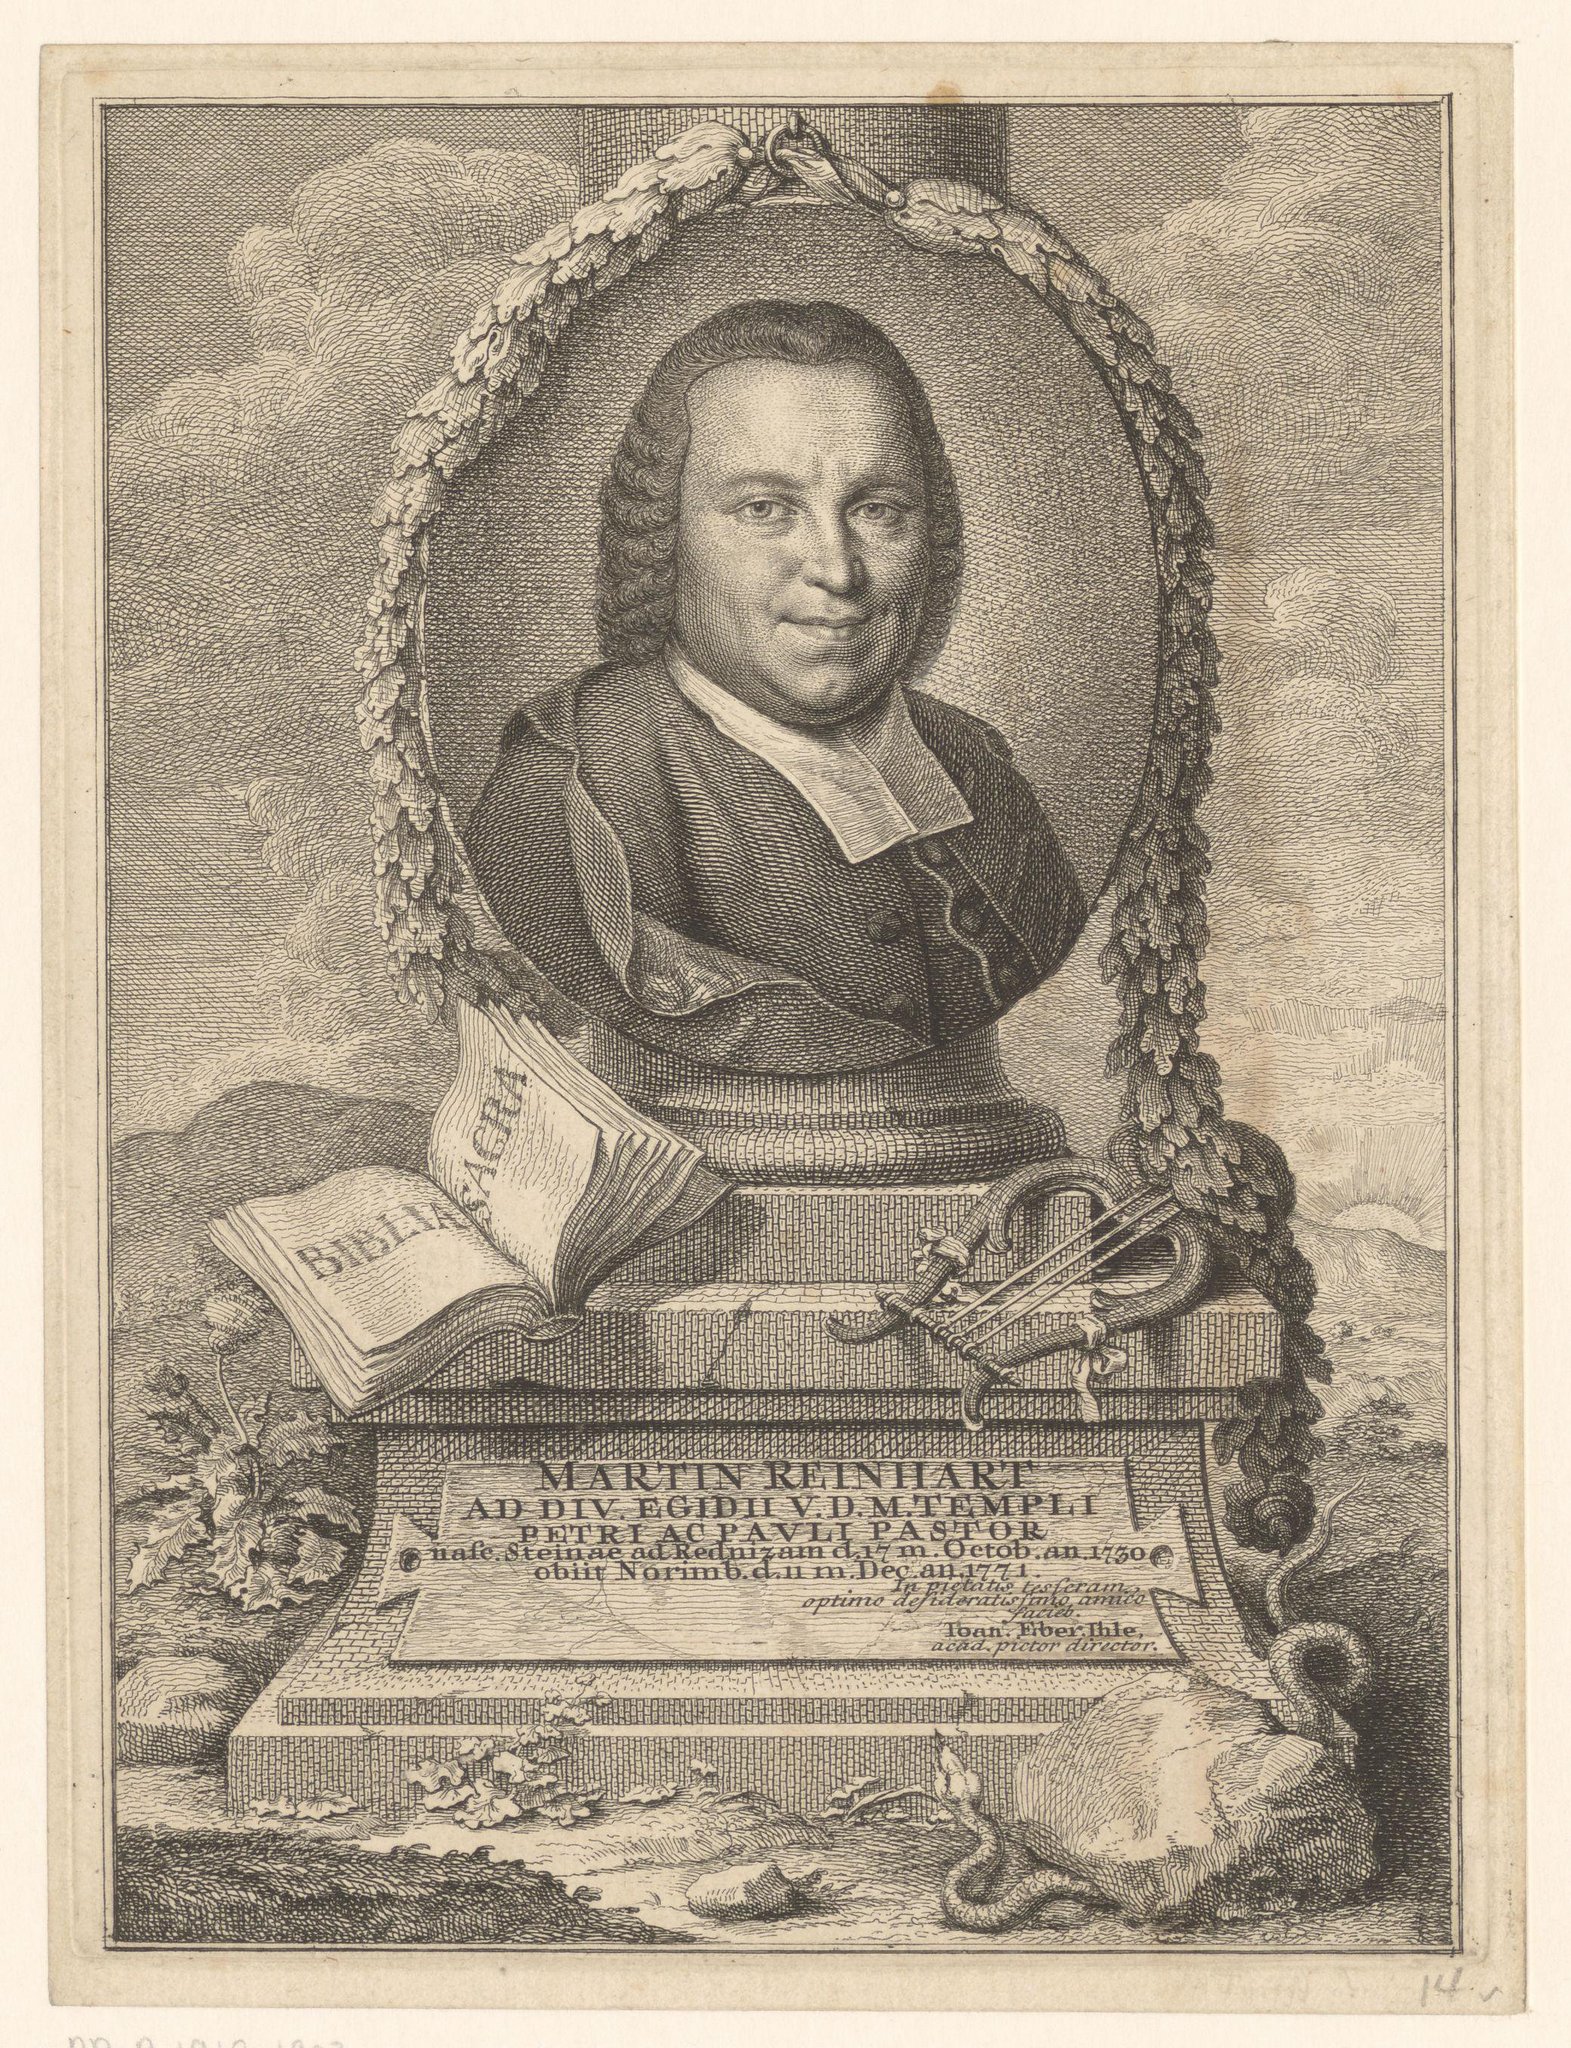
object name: print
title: Portret van Martin Reinhart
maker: johann eberhard ihle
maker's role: painter, print maker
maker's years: 1727-1814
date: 1763-1814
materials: paper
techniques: etching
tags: theologian, historical persons, biology (+ portrait of scholar, scientist)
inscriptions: collector's mark: Lugt 2228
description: Portret in ovale medaillon versierd met guirlandes opgehangen aan een zuil op een sokkel. Onderaan tekst in het Latijn over Reinhart's functie en zijn geboorte- en sterfdatum.